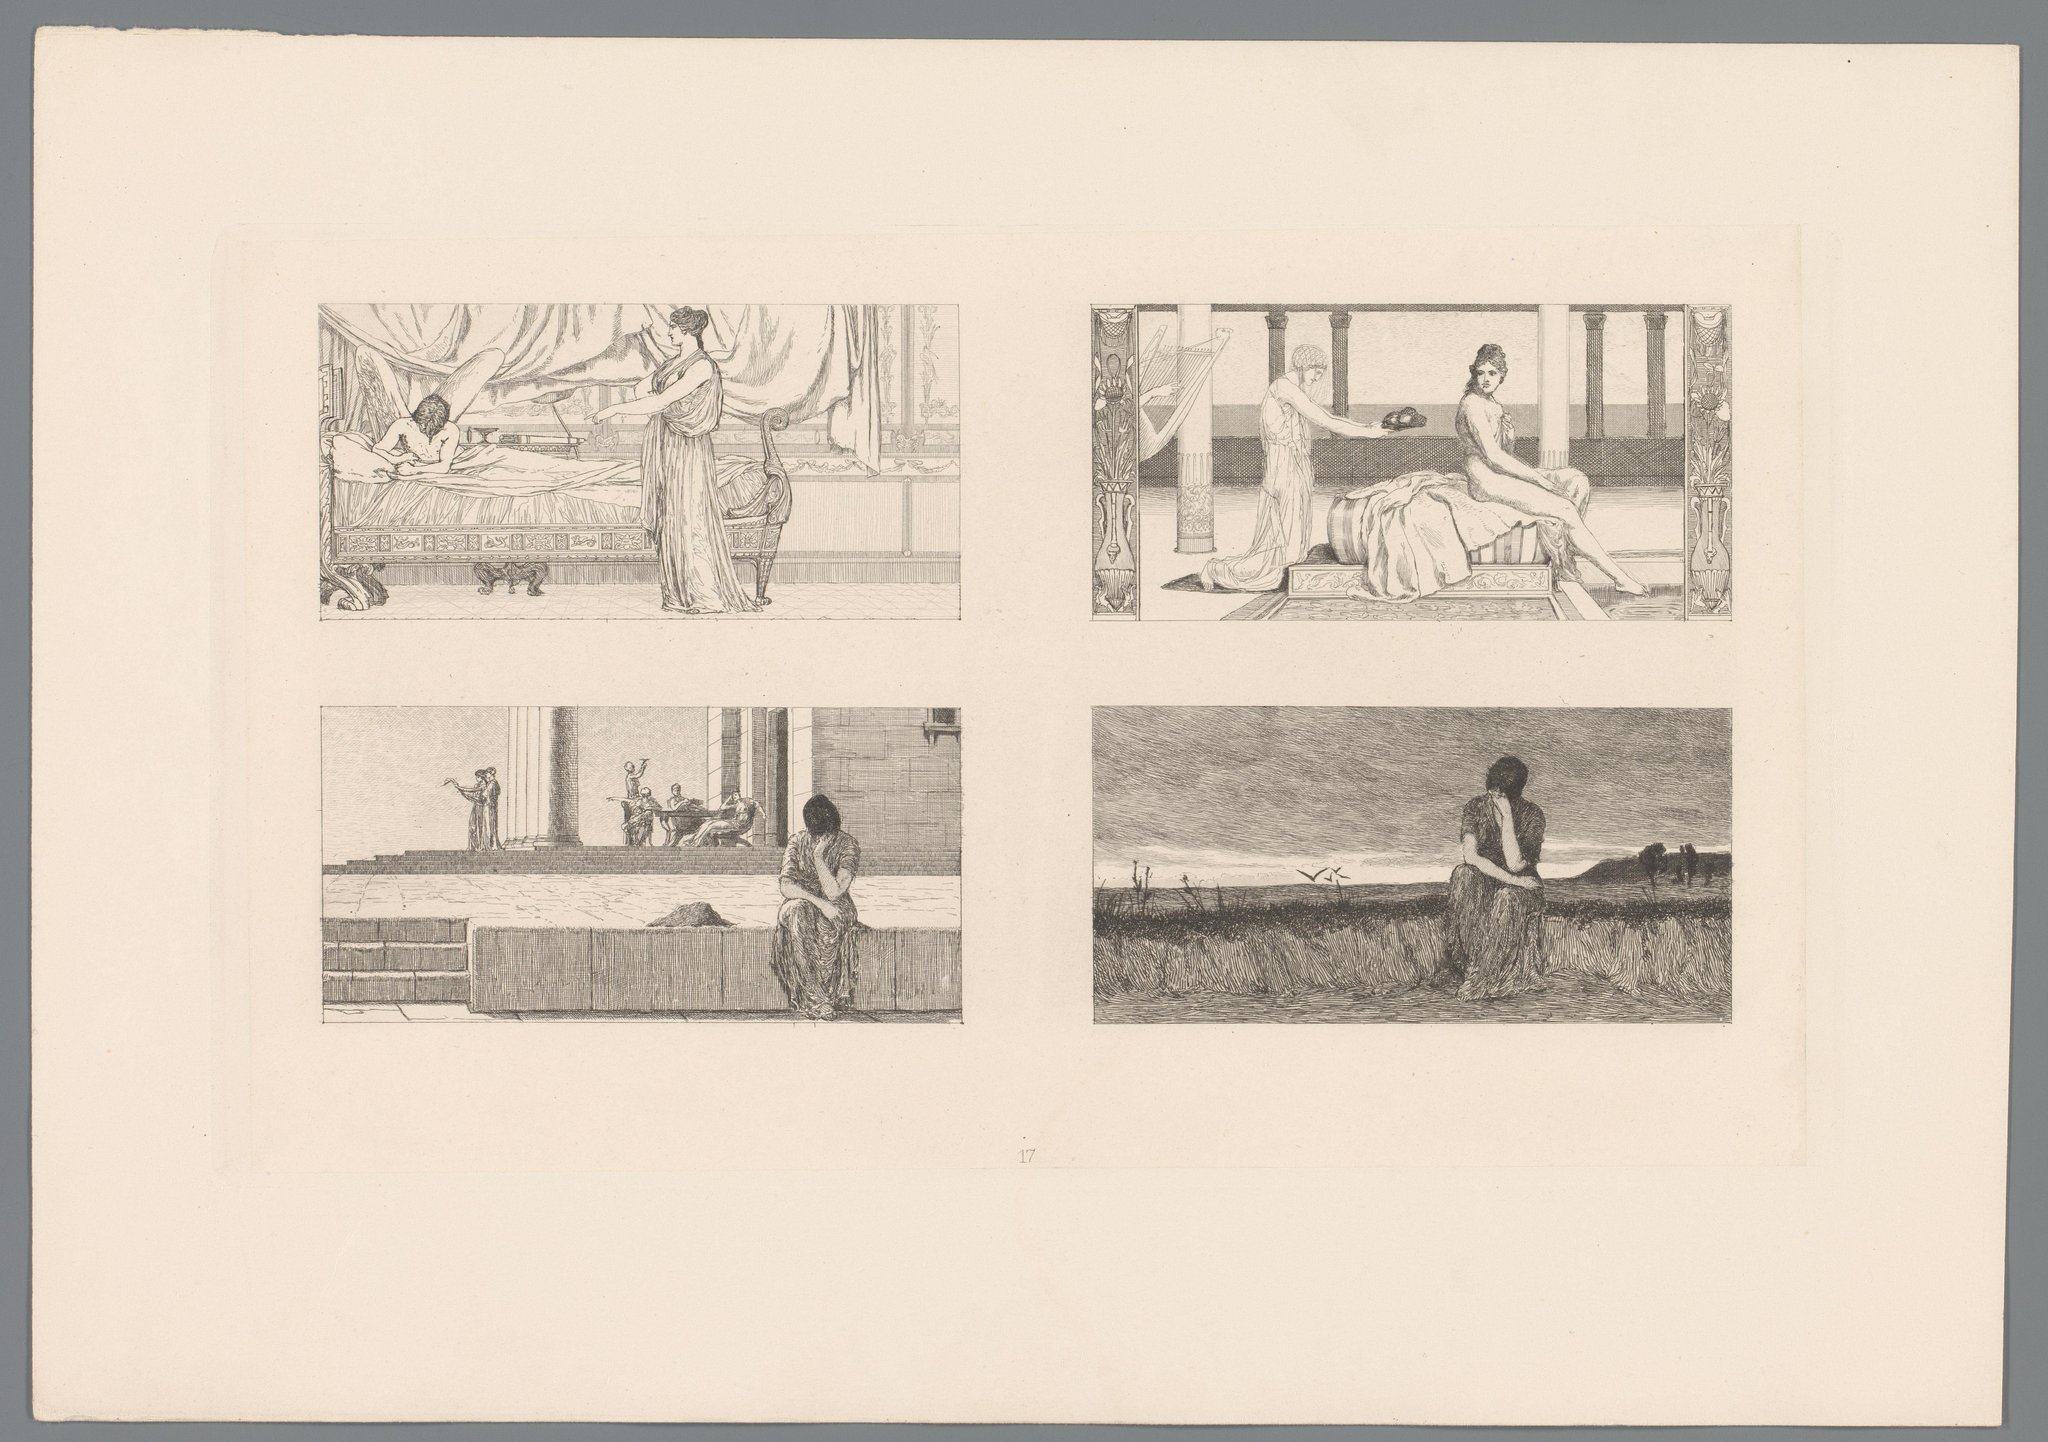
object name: print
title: Venus im Gemache Amors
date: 1880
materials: paper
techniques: aquatint, etching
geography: nuremberg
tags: other scenes from the story of cupid and psyche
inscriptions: collector's mark: Lugt 2228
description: Vier afbeeldingen op een prent: Venus in het vertrek van Amor, Psyche badend, Psyche in het huis van Venus, en Psyche rustend.